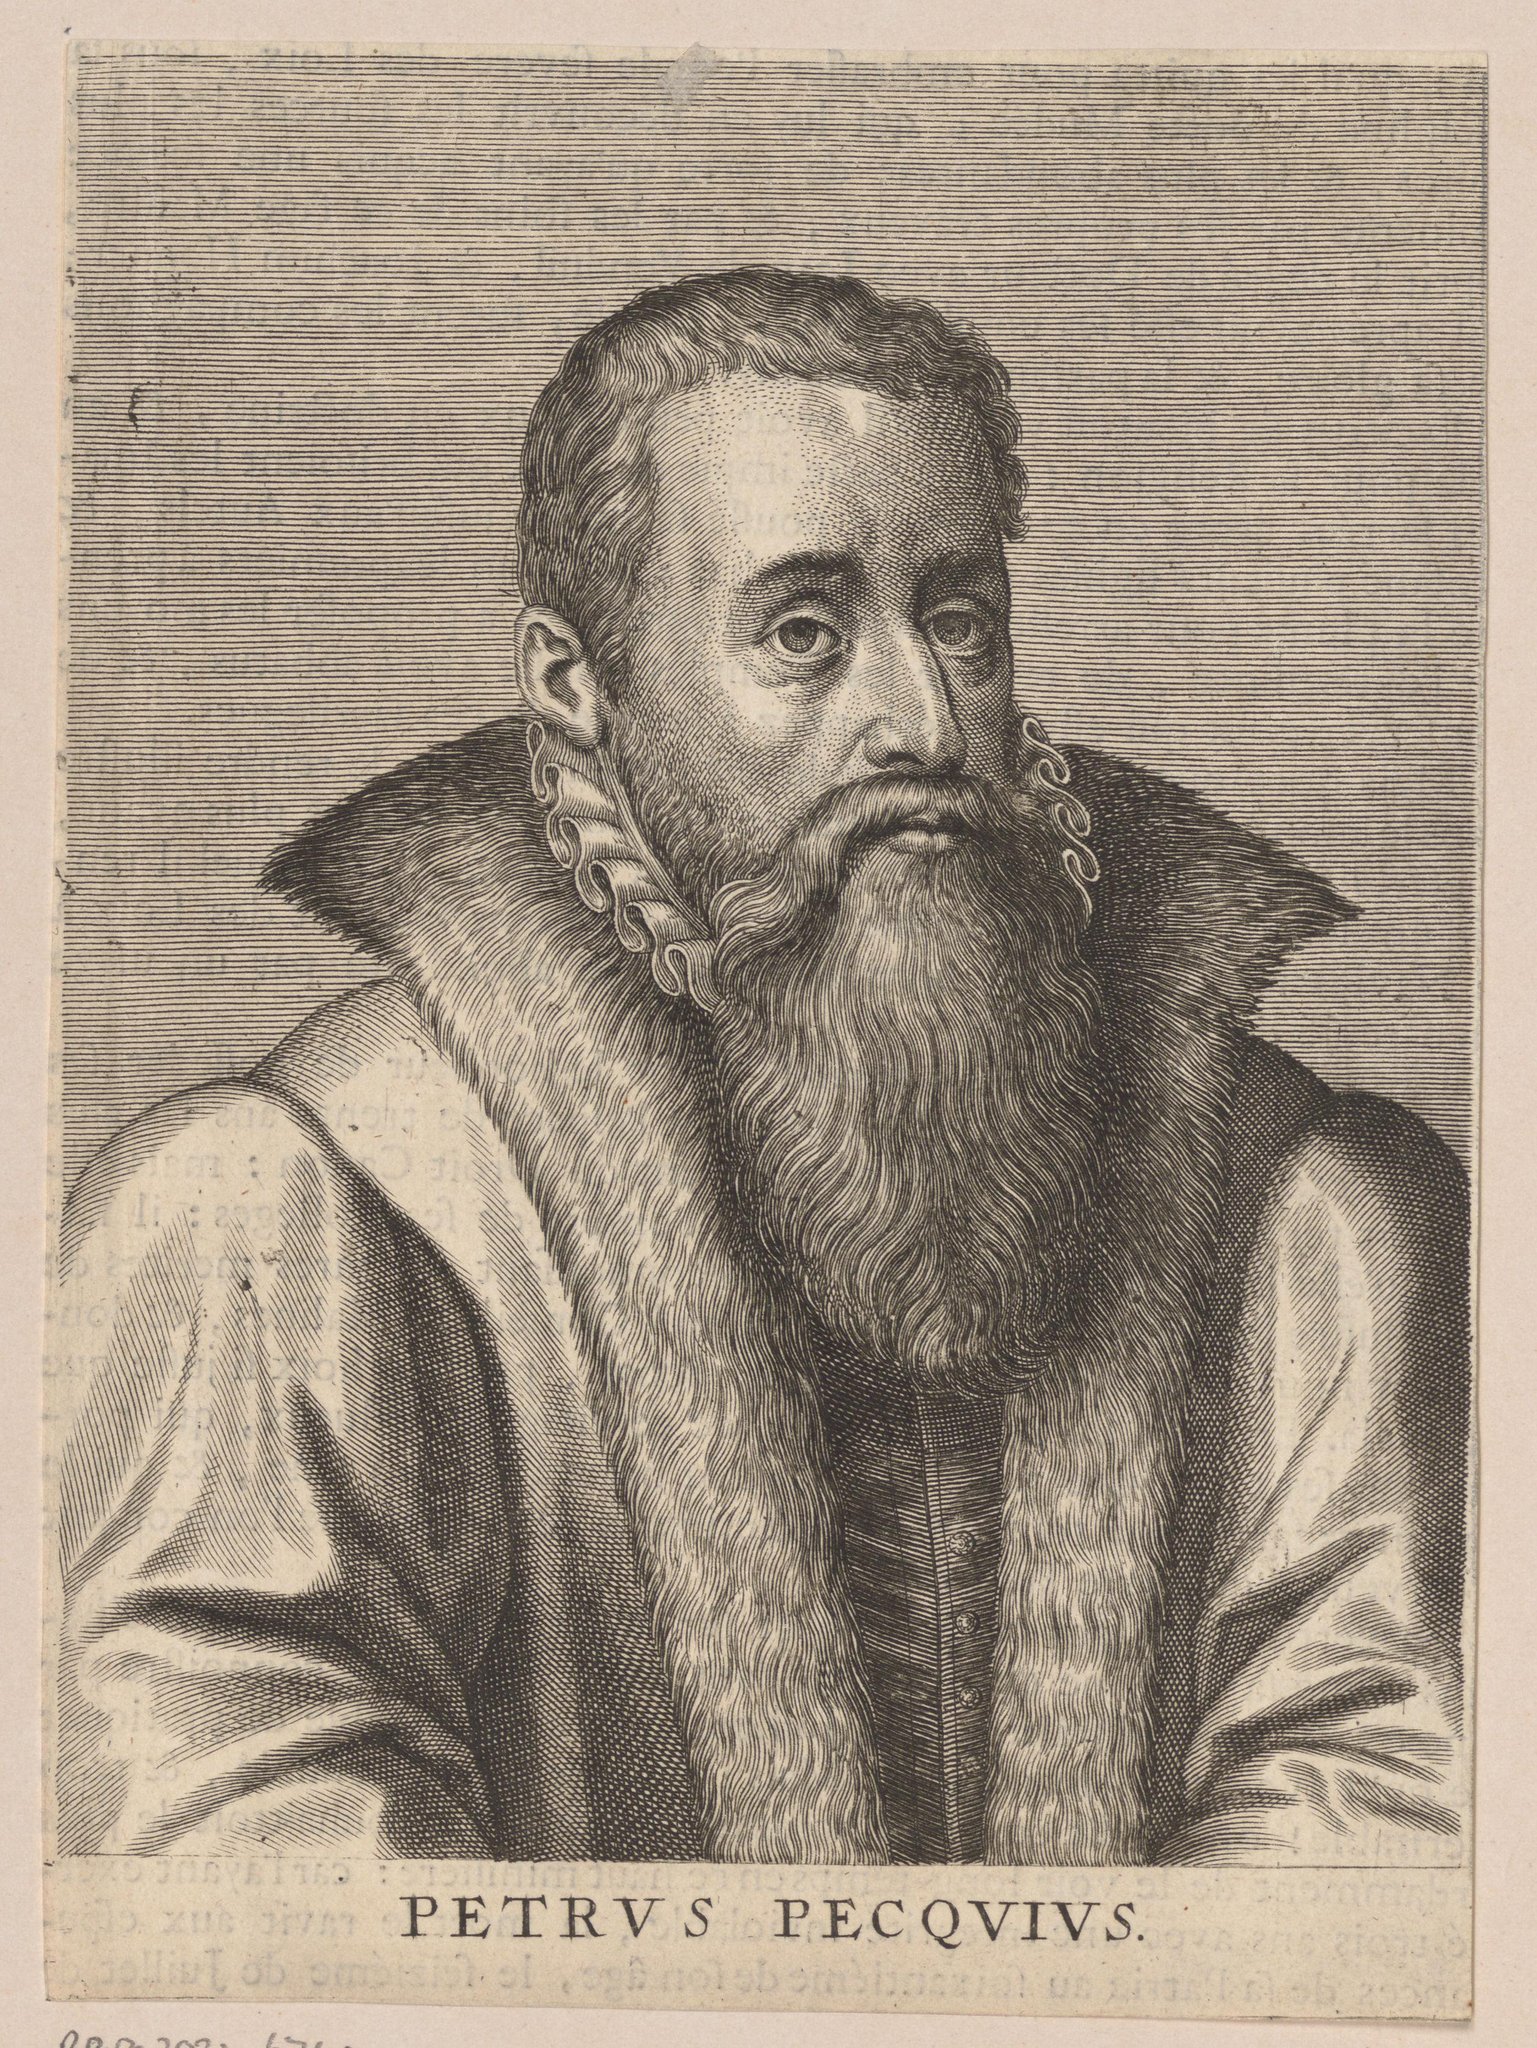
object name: book illustration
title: Portret van Pieter Peck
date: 1682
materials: paper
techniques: engraving, letterpress printing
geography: brussels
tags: mechelen, adult man, historical persons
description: Prent uit: Bullart, Isaac. Académie des sciences et des arts, contenant les vies et les éloges historiques des hommes illustres. Brussel: François Foppens, 1682, dl. 1.